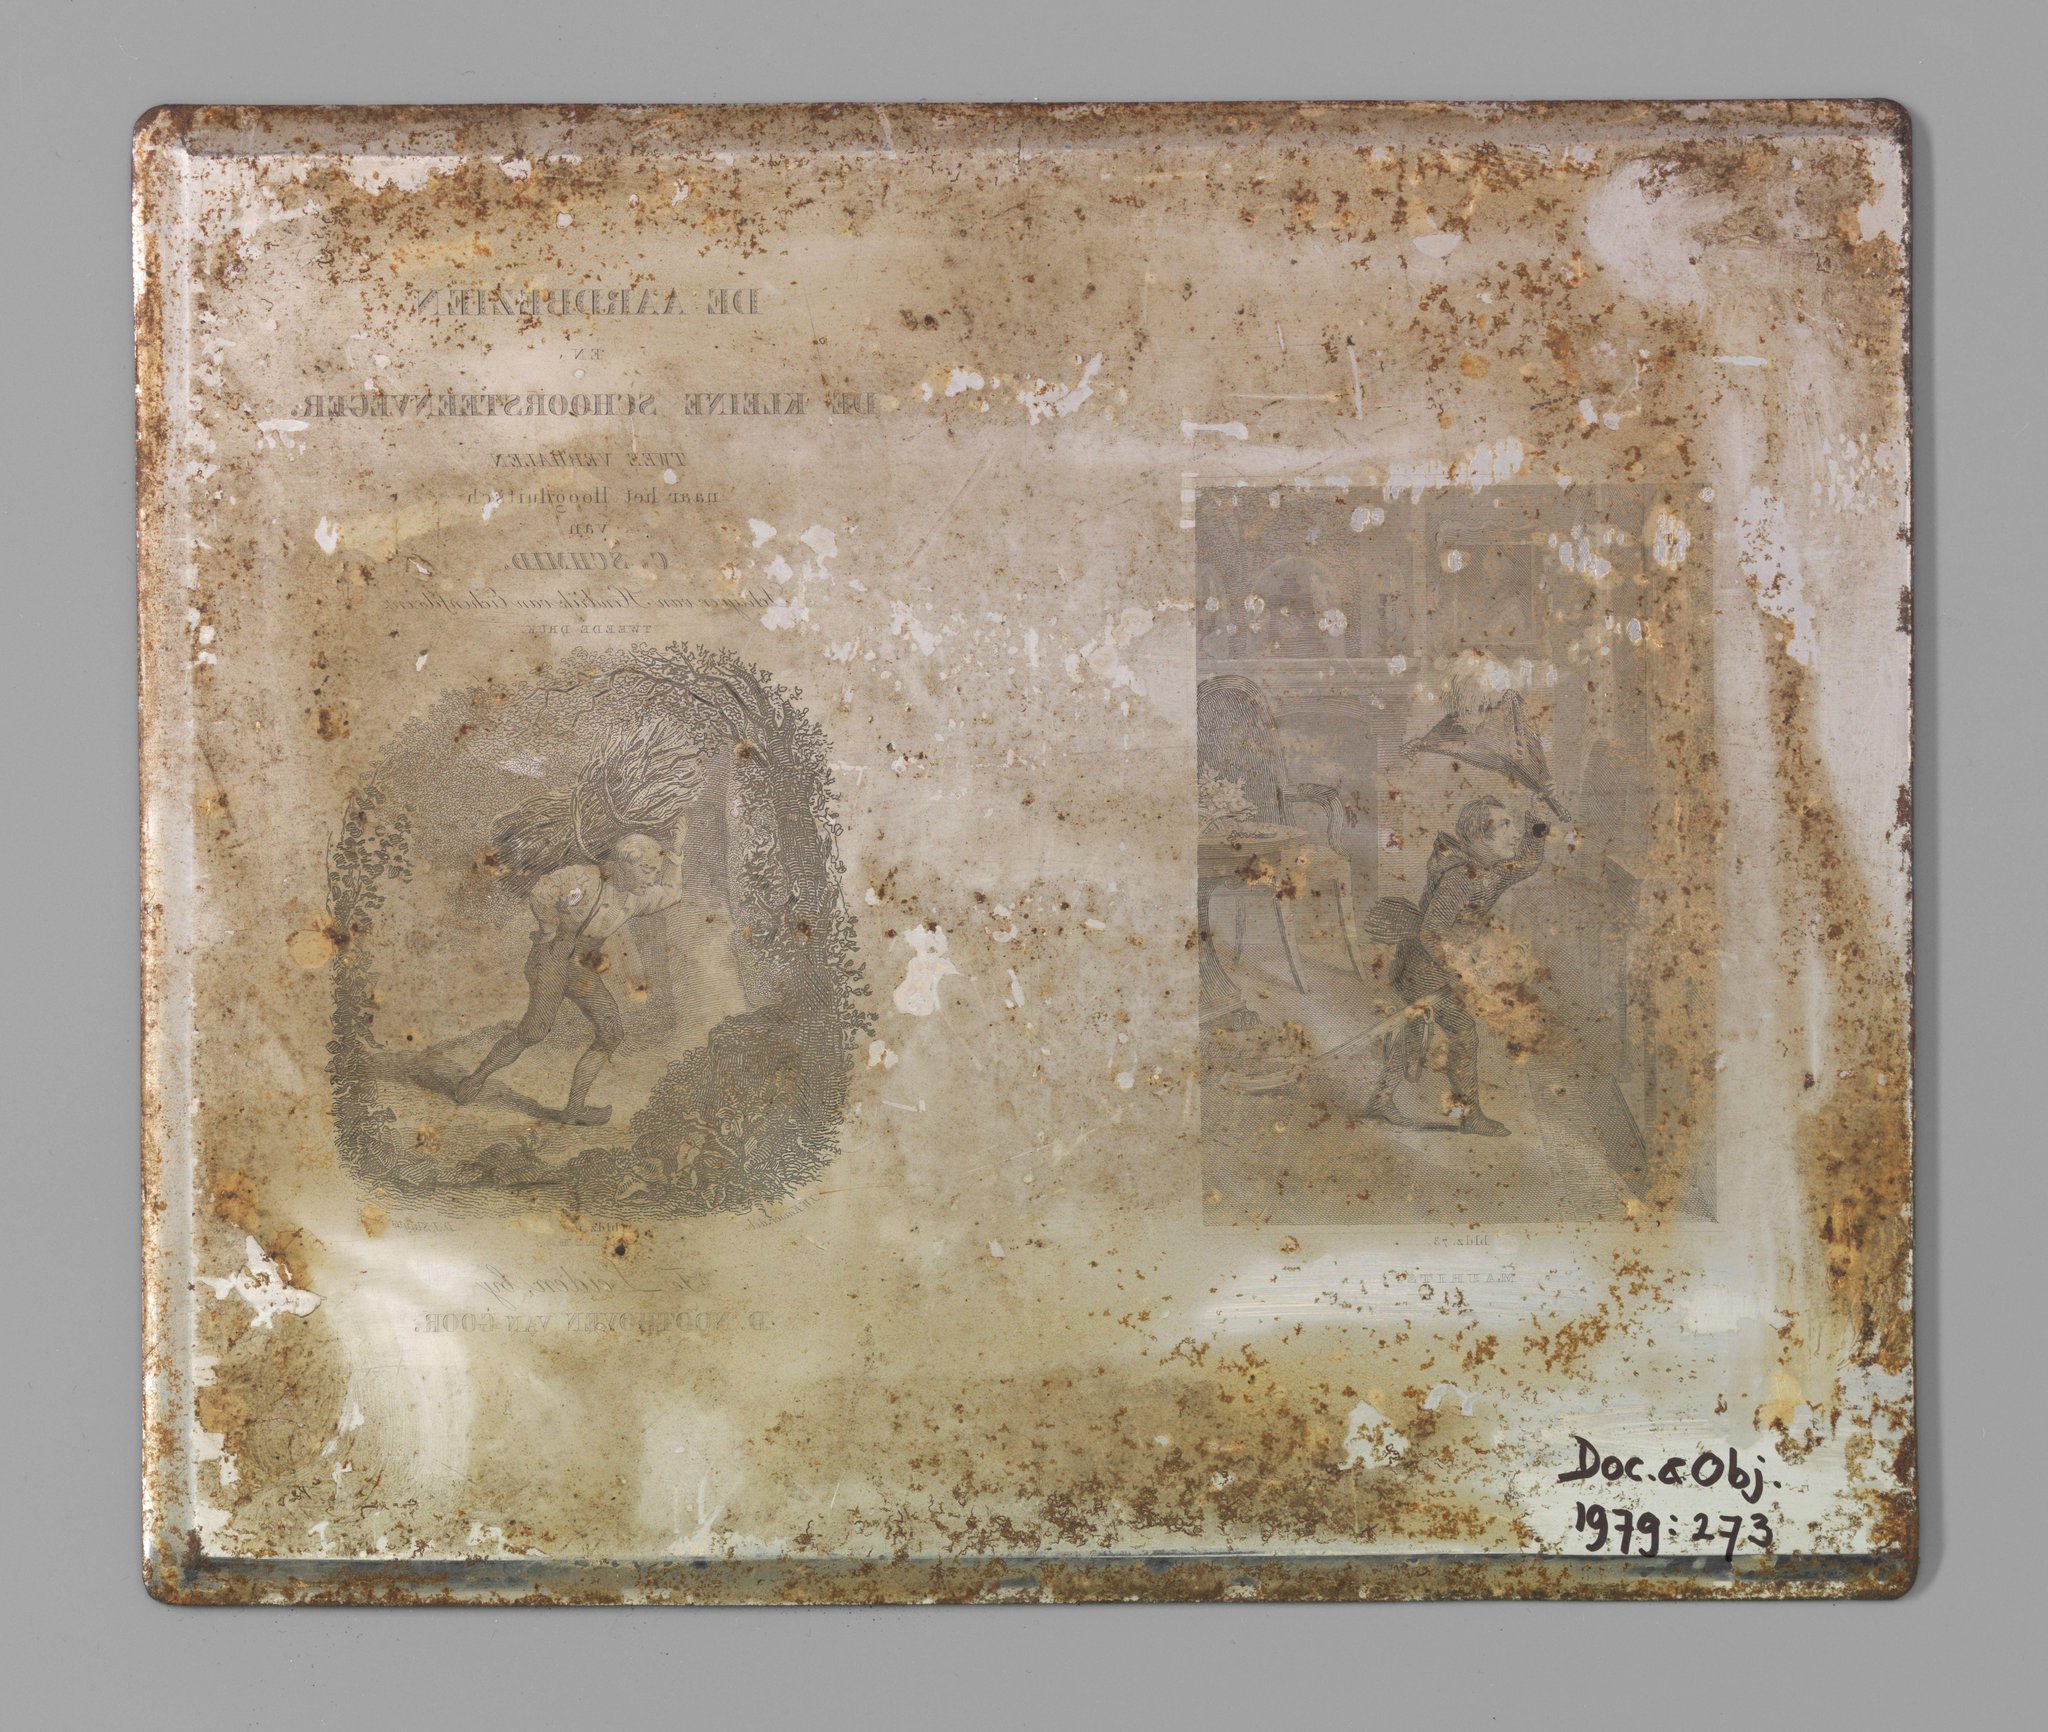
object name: staalplaat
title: 'De Aardbezien' en 'De kleine schoorsteenveger'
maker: dirk jurriaan sluyter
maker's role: draughtsman, print maker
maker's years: 1811-1886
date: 1811-1886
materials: steel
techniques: engraving